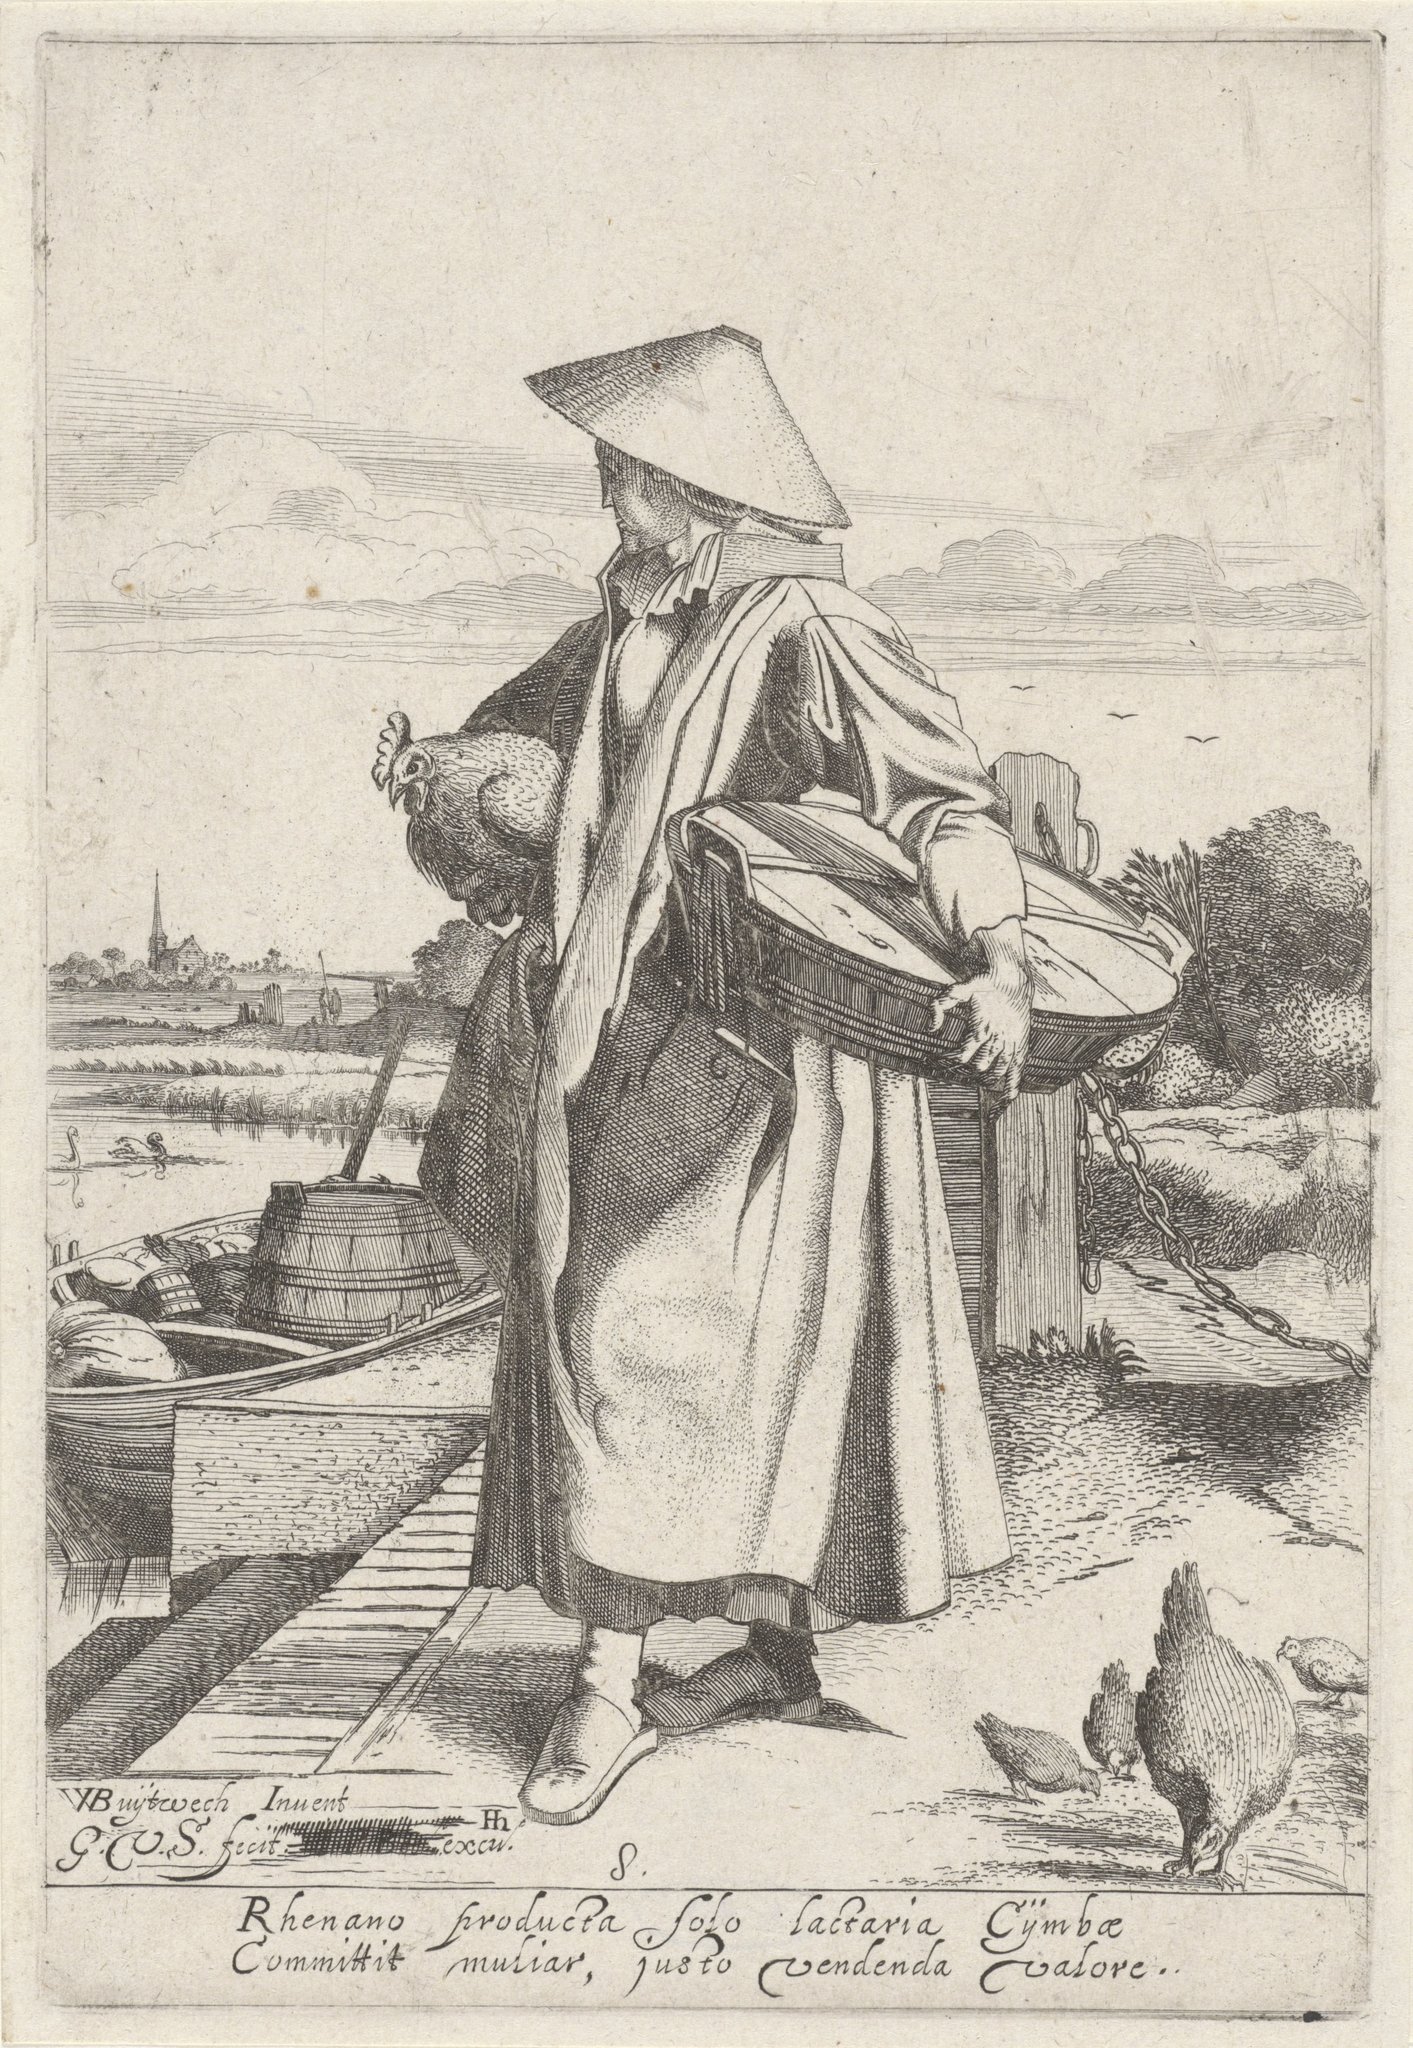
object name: print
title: Meisje uit Rijnland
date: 1620-1624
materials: paper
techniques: engraving, etching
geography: northern netherlands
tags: folk costume, regional costume, rhineland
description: Staande jonge vrouw uit Rijnland. Nr. 8 in een serie van acht jonge vrouwen in Noord-Hollandse klederdrachten. Met onderschrift van twee regels in het Latijn.